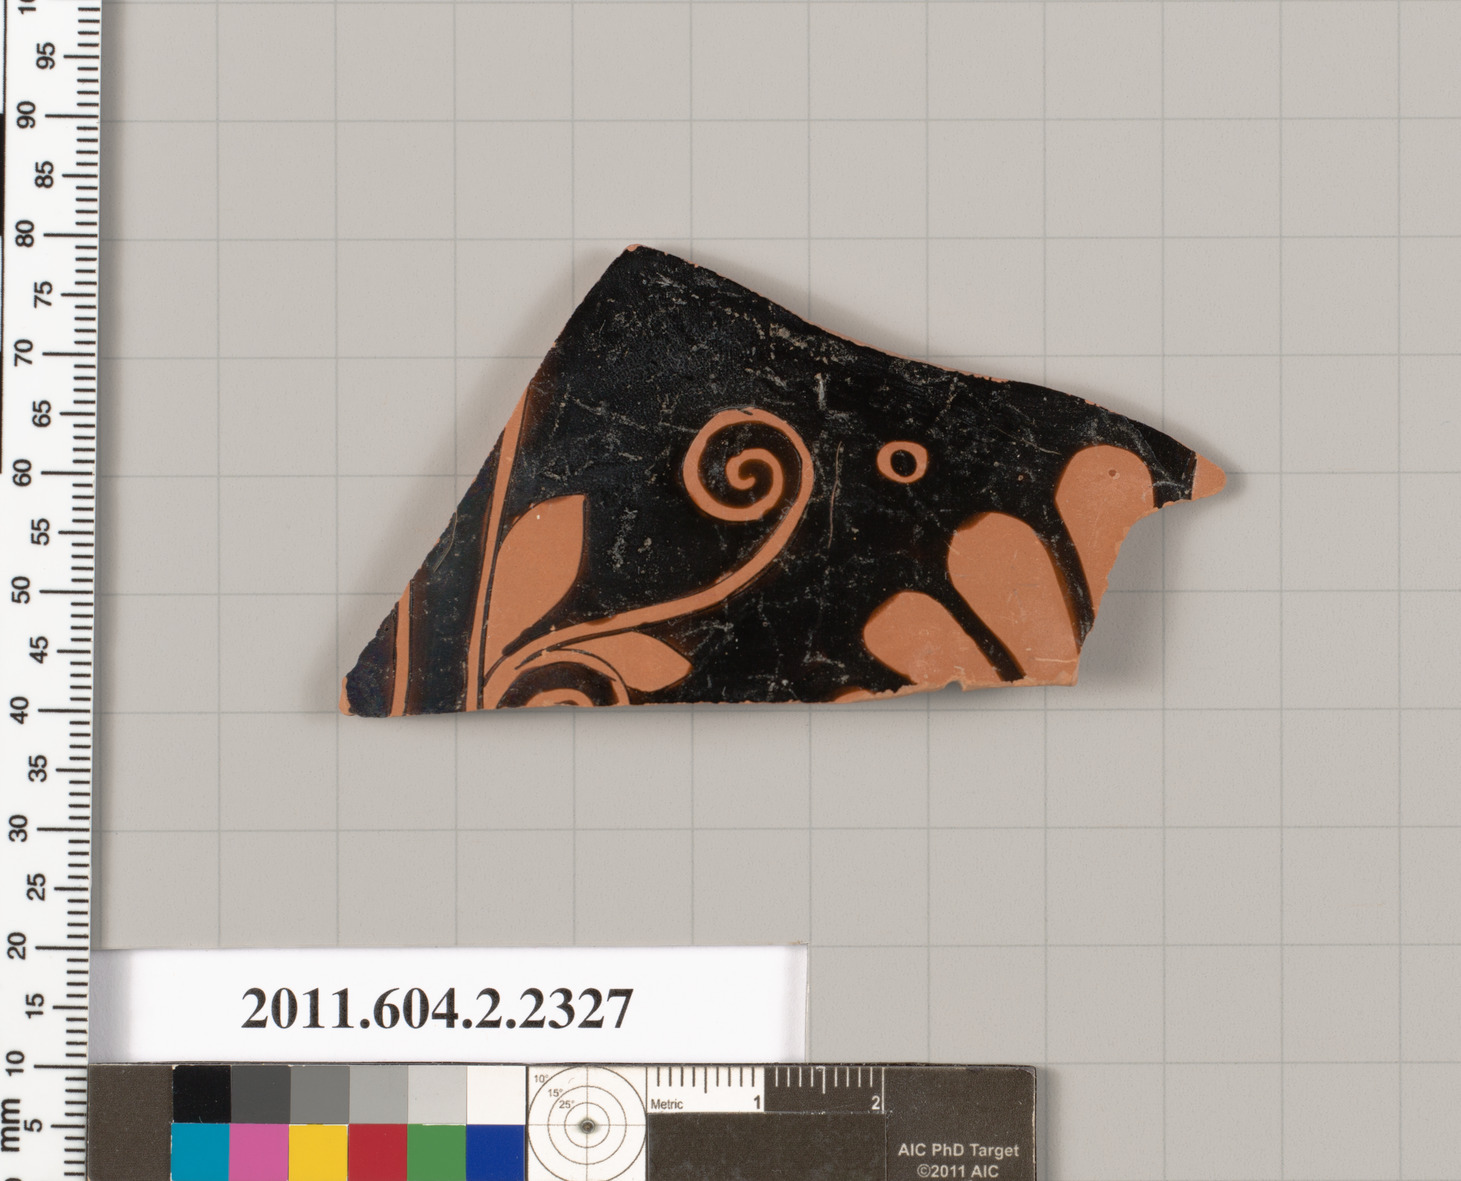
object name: skyphos fragment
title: Terracotta fragment of a skyphos (deep drinking cup)?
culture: greek, attic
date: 460-450 BCE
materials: terracotta